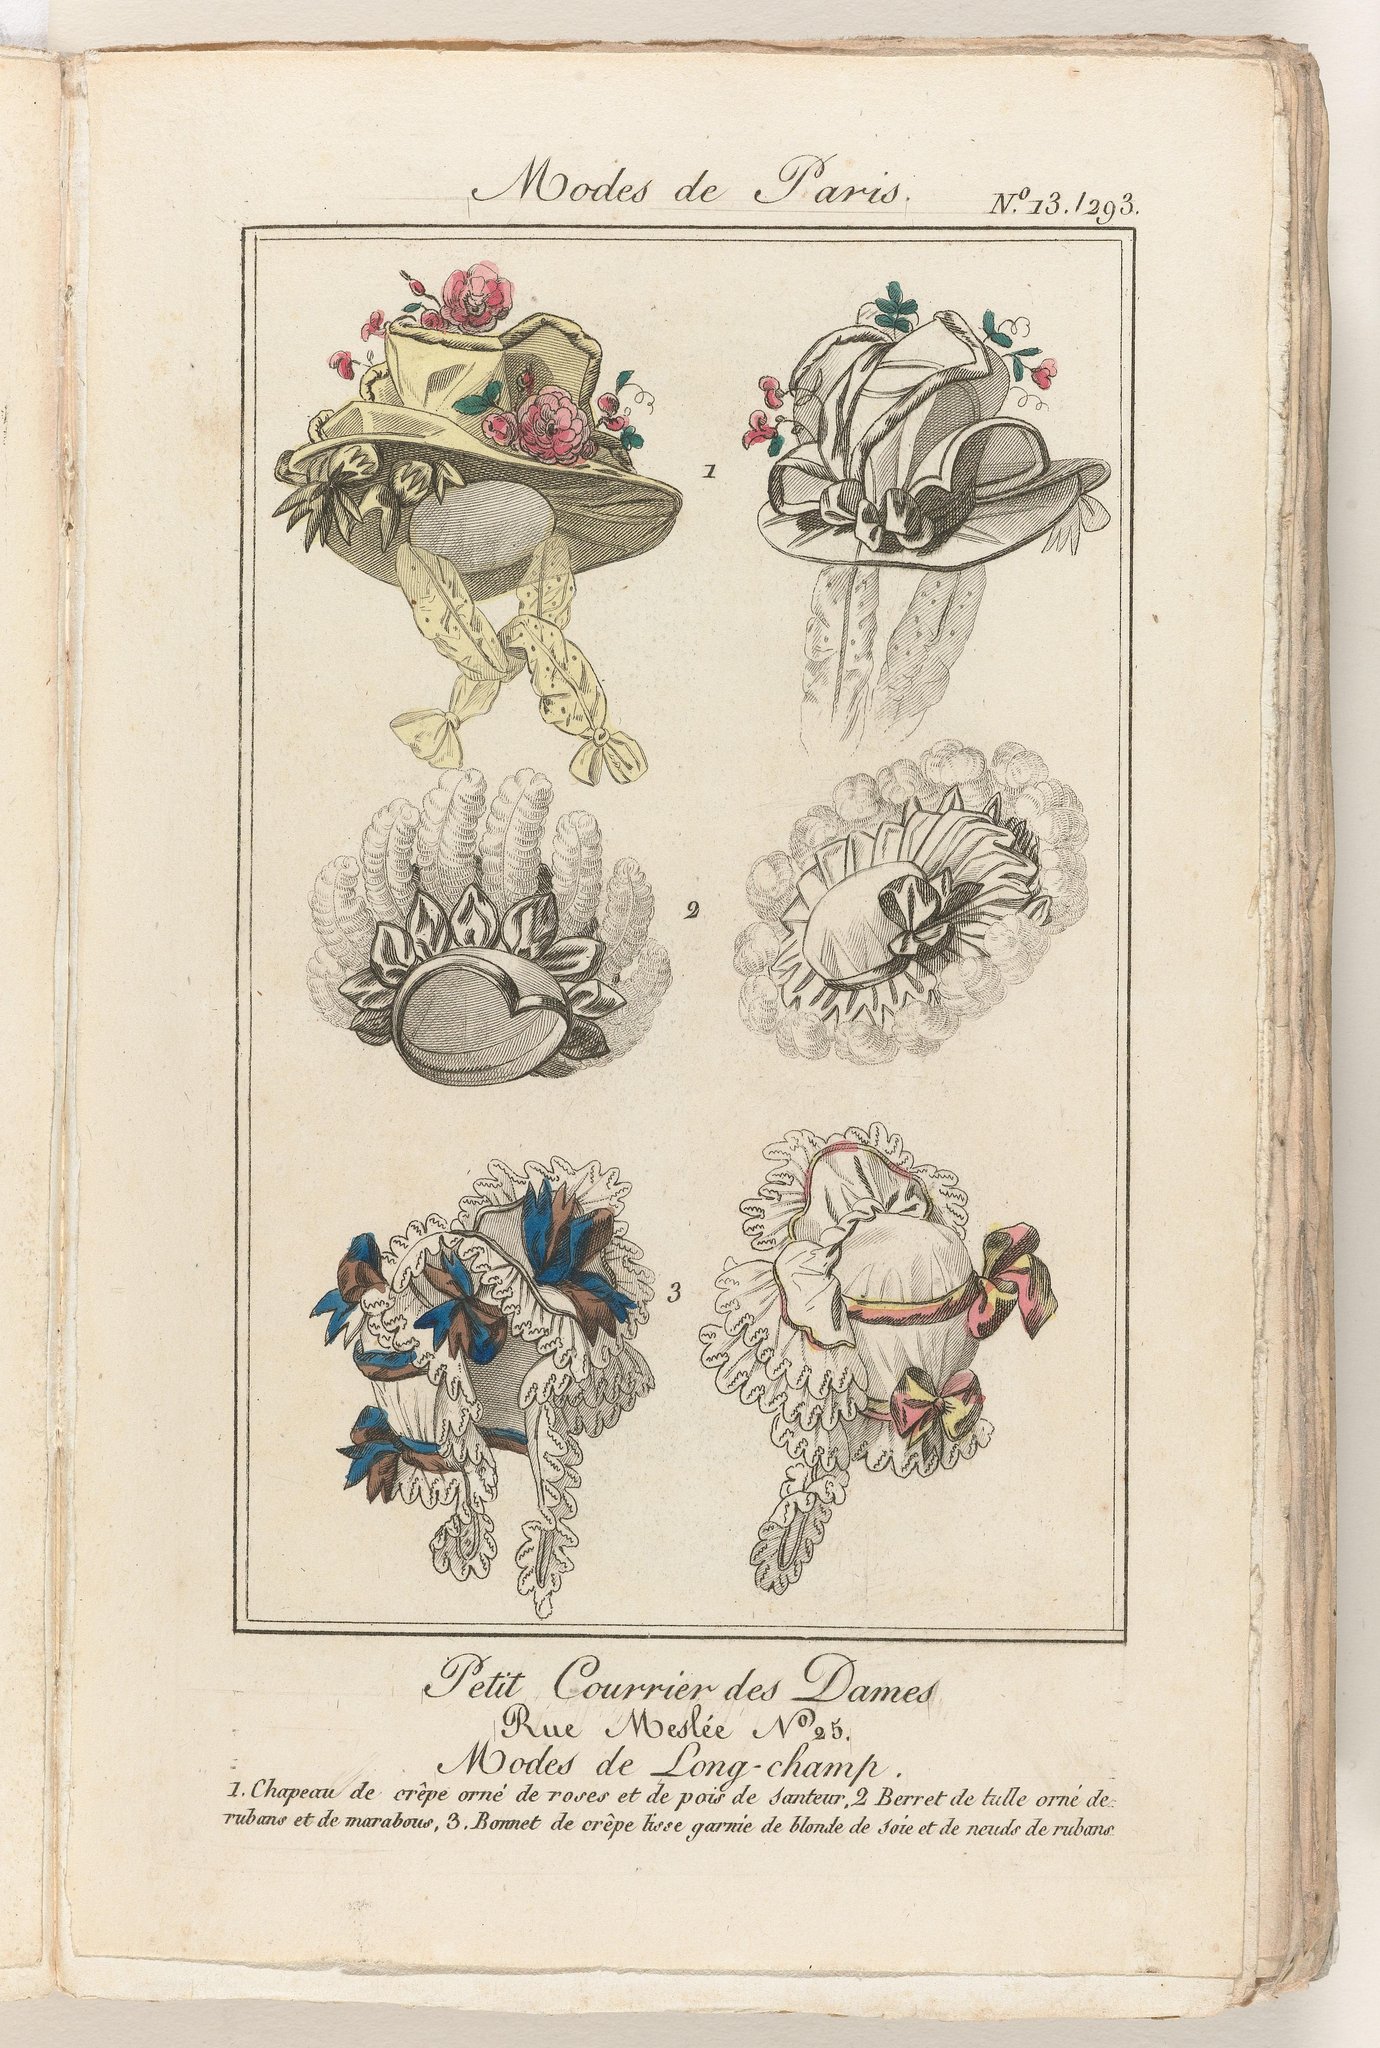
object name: magazine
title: Petit Courrier des Dames 1825 (No. 13/293)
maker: Anonymous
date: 1825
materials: paper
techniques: engraving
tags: fashion plates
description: Prent uit het modetijdschrift Petit Courrier des Dames (1821-1868).